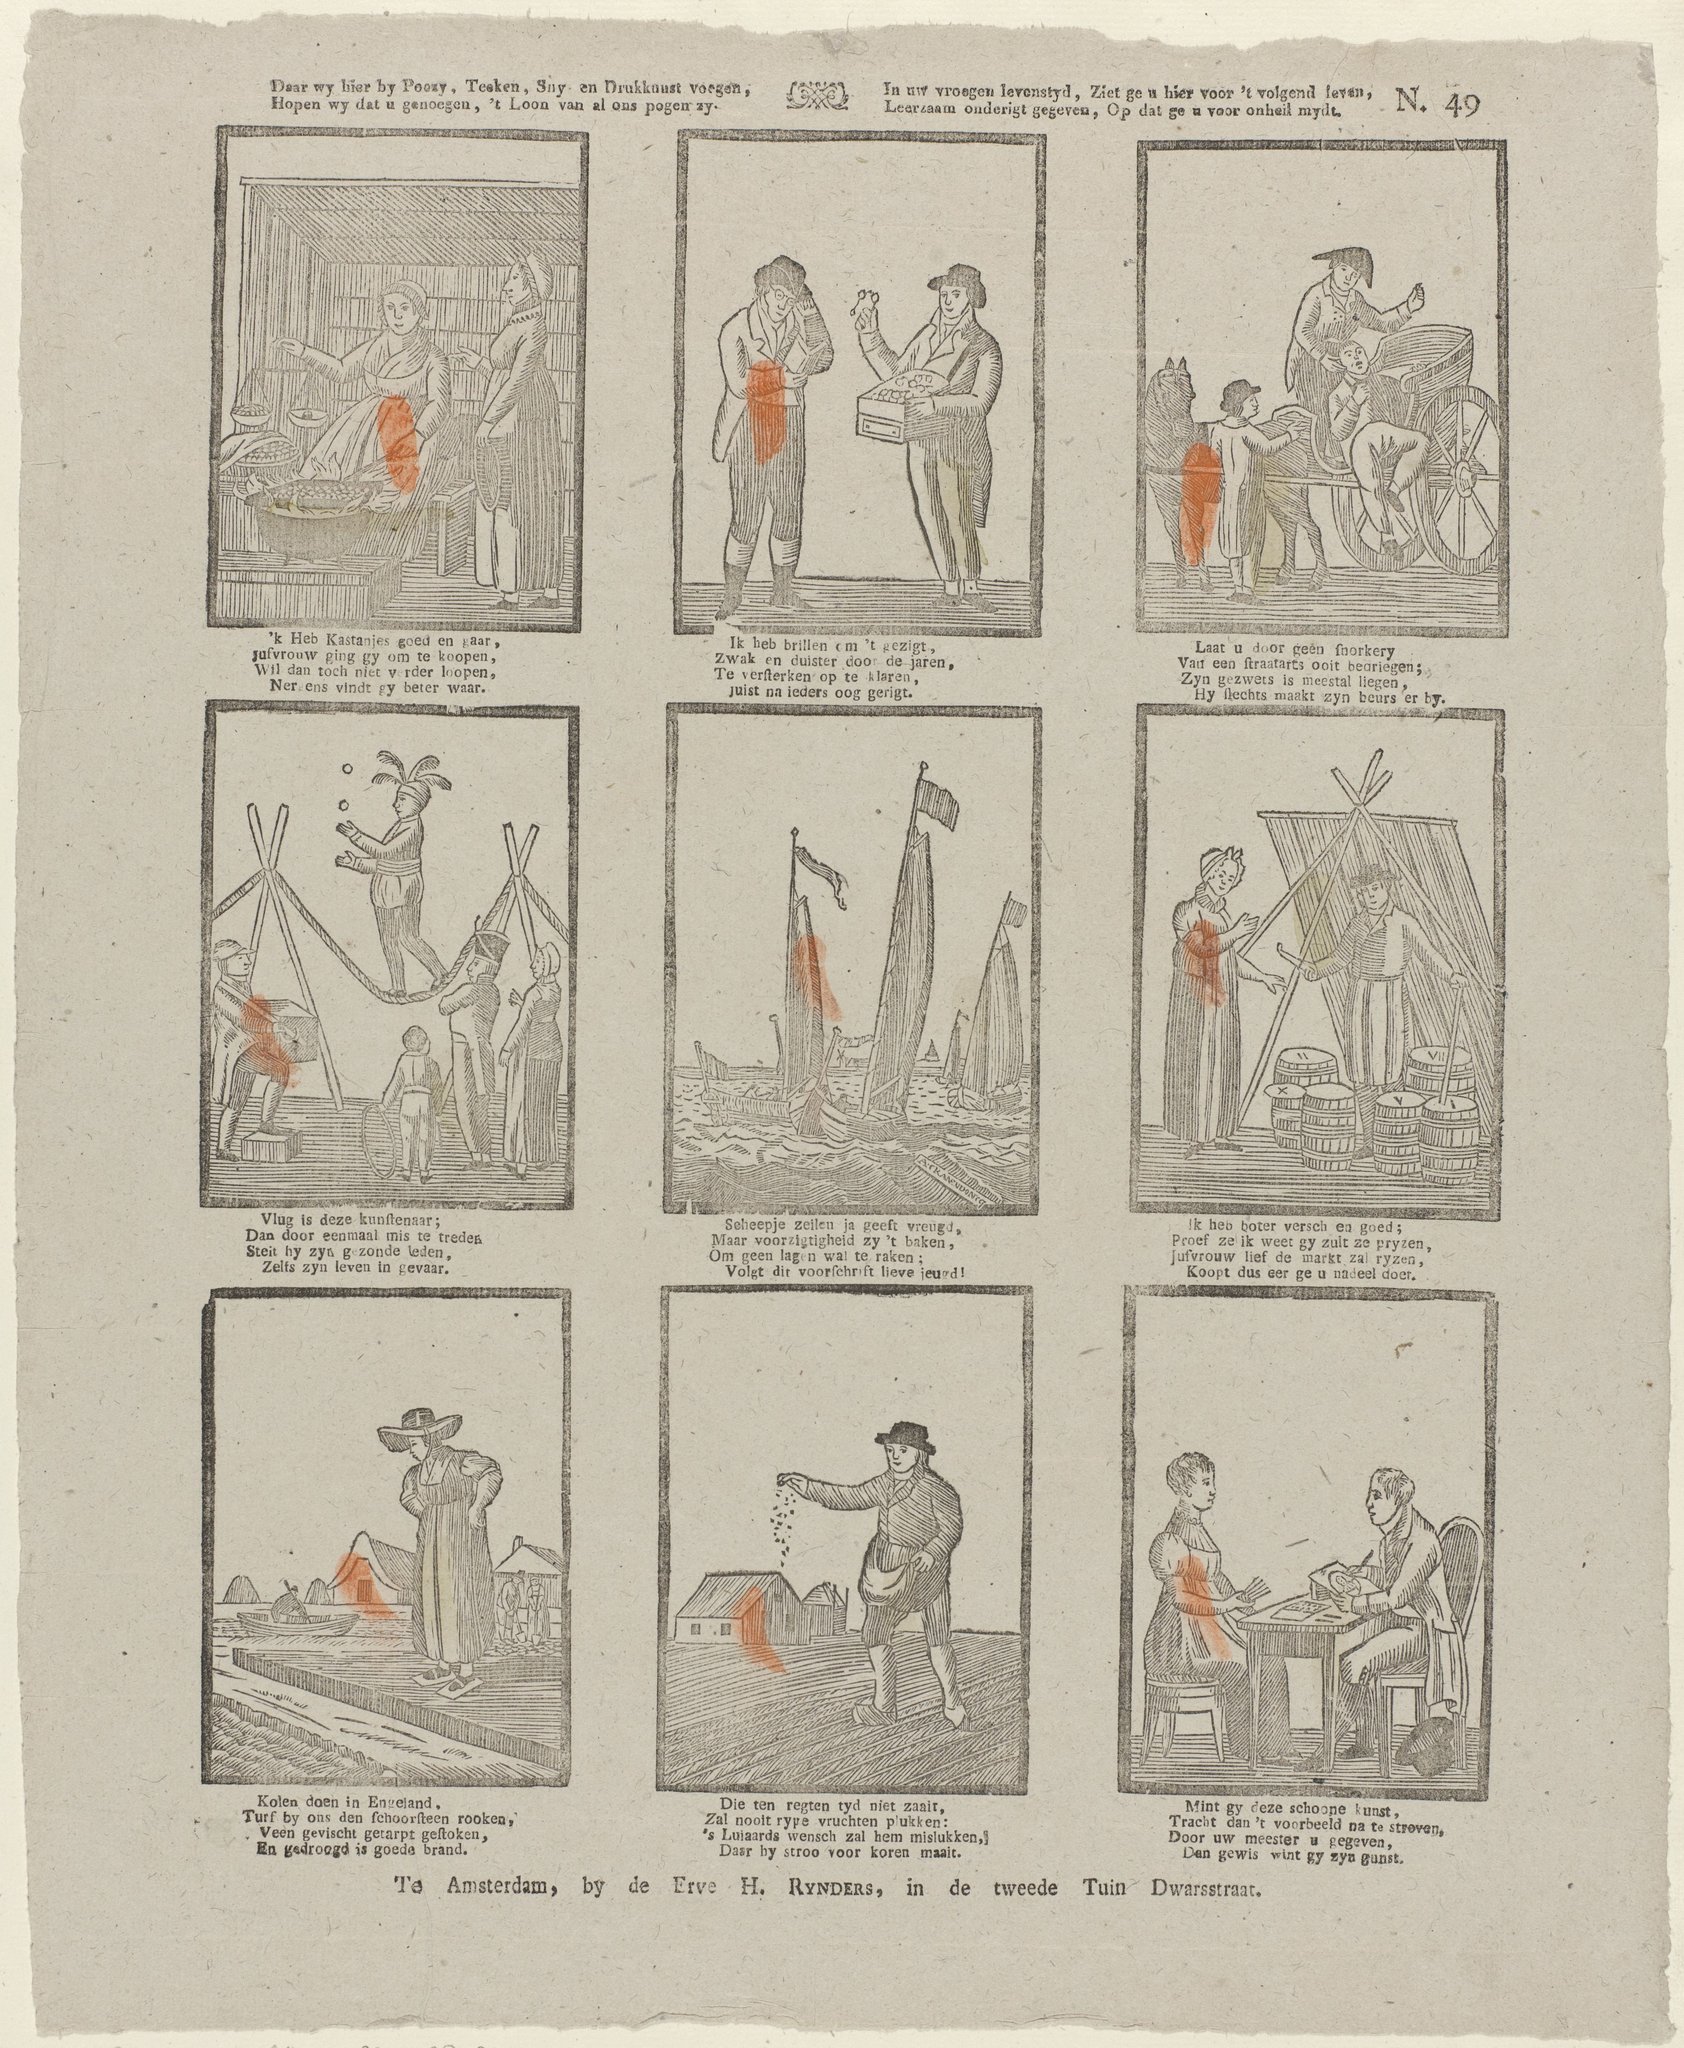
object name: popular print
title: Daar wy hier by poezy, teeken, sny en drukkunst voegen, / Hopen wy dat u genoegen, 't loon van al ons pogen zy. / In uw vroegen levenstyd, ziet ge u hier voor 't volgend leven, / Leerzaam onderigt gegeven, op dat ge u voor onheil mydt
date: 1782-1854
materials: paper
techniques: colour, letterpress printing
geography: amsterdam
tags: street-trader, tight-ropewalker, merchant, salesman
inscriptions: collector's mark: Lugt 2760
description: Blad met 9 voorstellingen van kooplieden die hun waar aanprijzen en personen die wijze raad geven. Onder elke afbeelding een vierregelig vers. Genummerd rechtboven: N. 49.